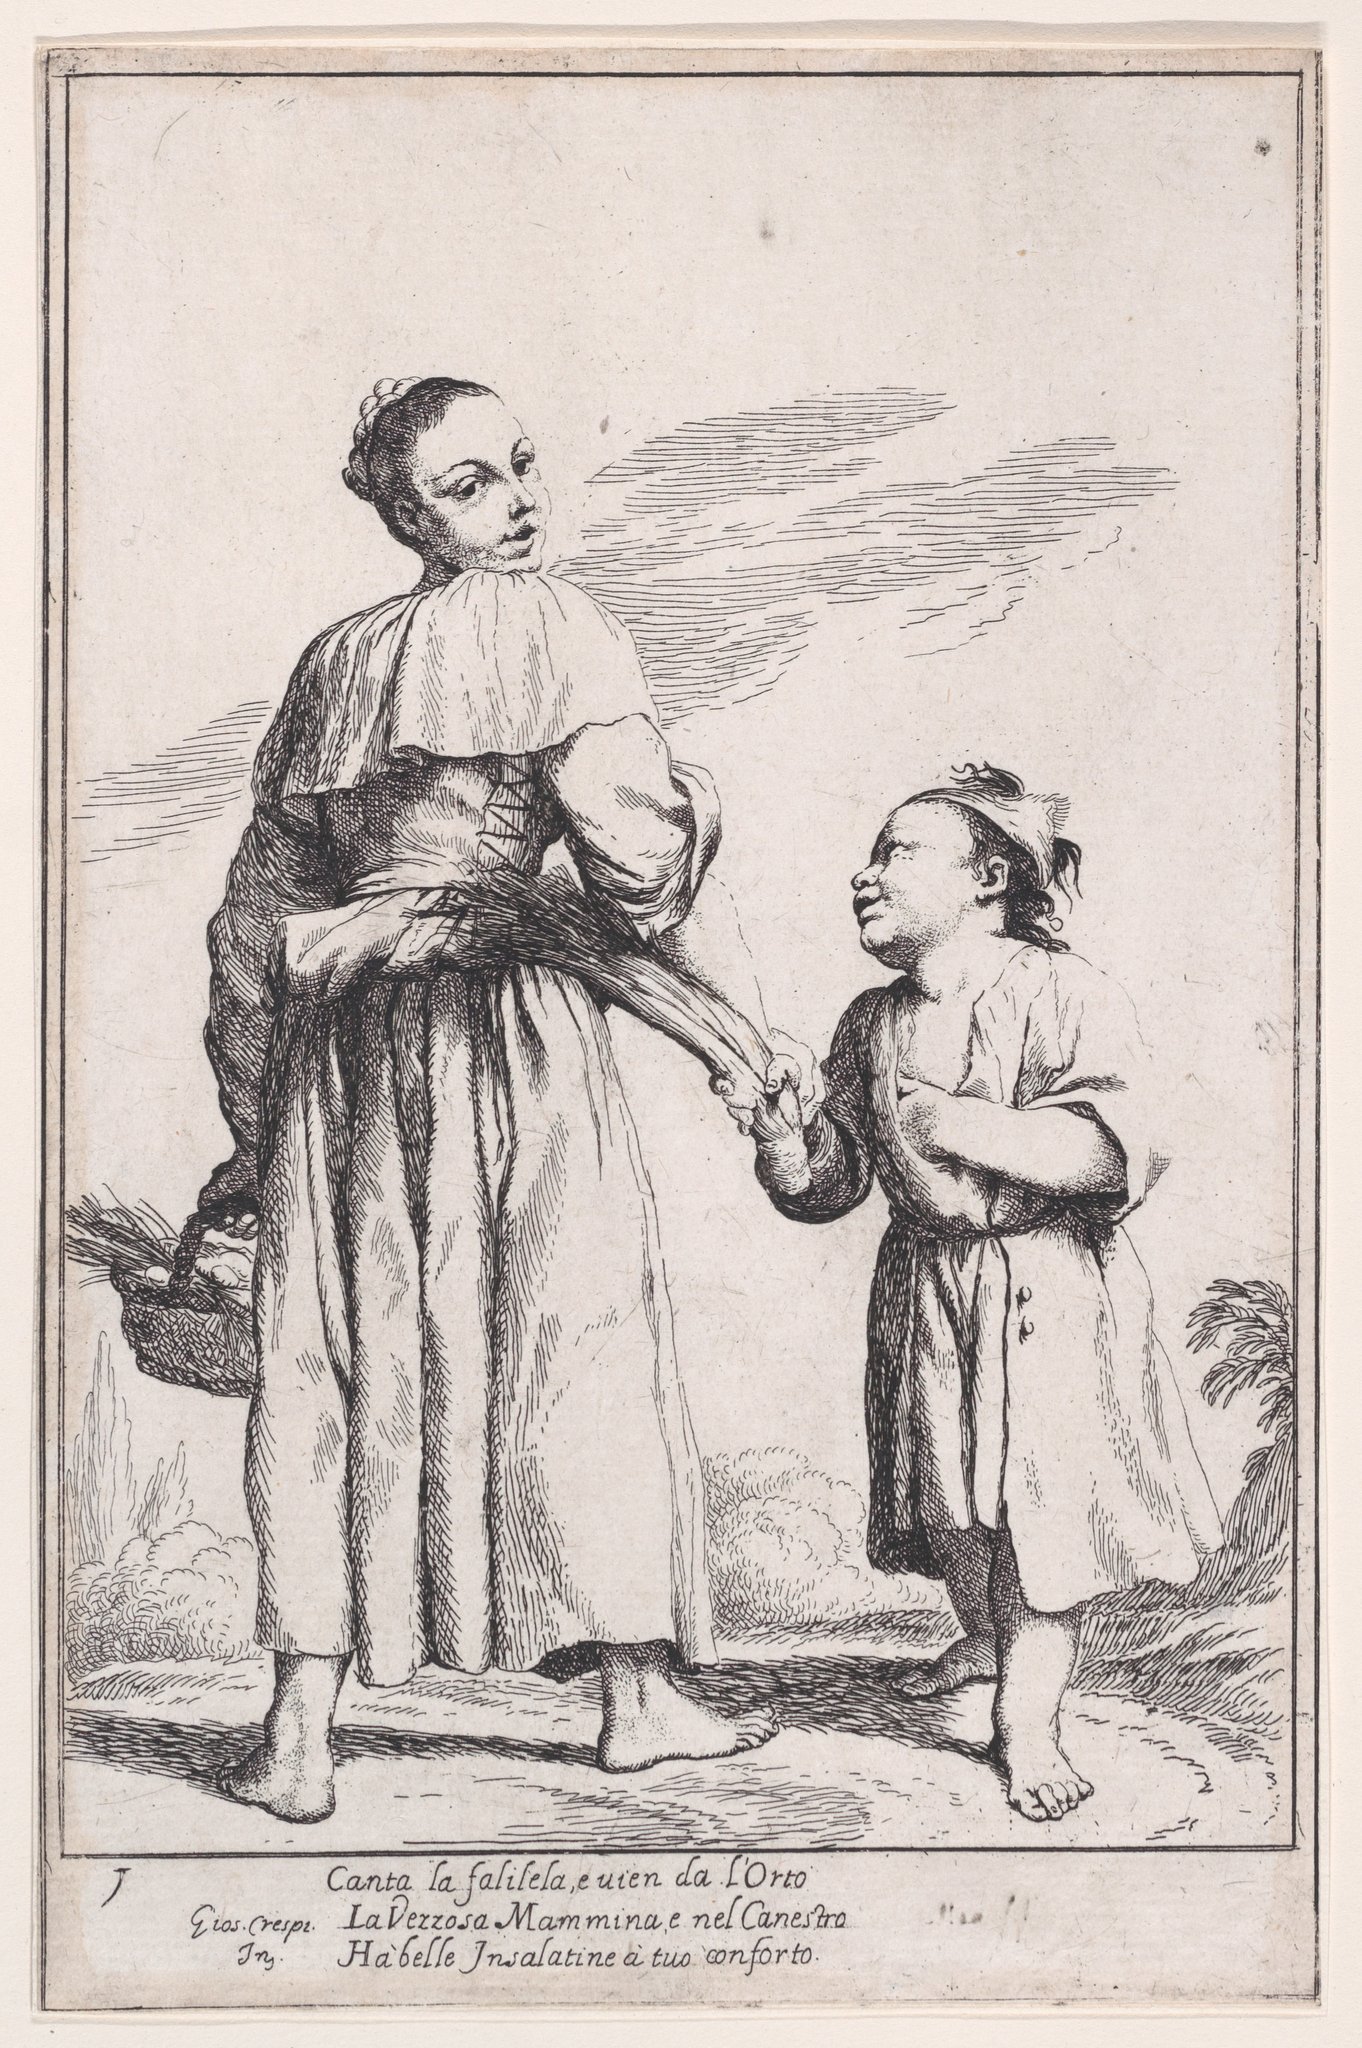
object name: print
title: Plate 15: Menghina leaving the garden with a basket filled with herbs and encountering Cacasenno, from "Bertoldo, Bertoldino, and Cacasenno"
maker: giuseppe maria crespi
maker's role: artist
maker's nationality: italian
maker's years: 1665-1747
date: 1705-1715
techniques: etching